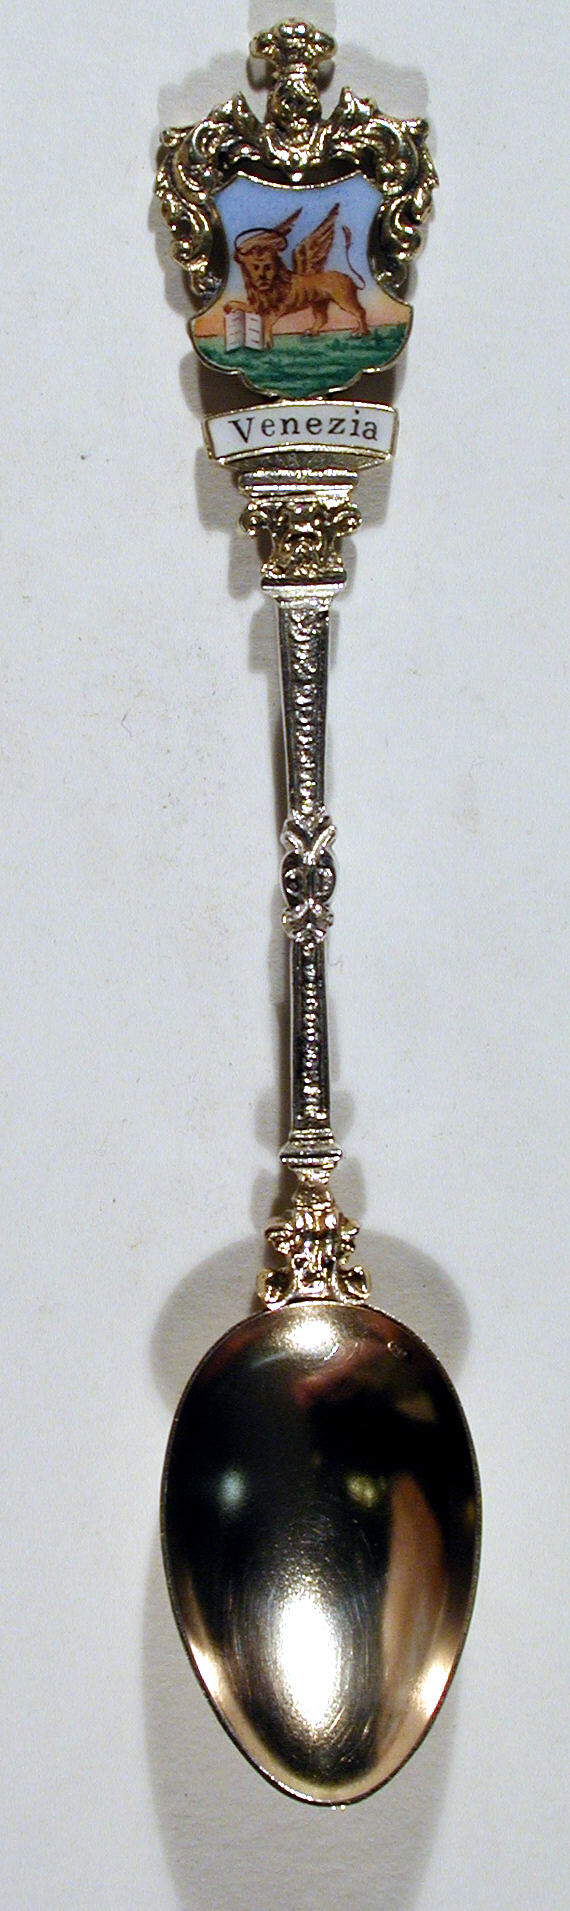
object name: souvenir spoon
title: Souvenir spoon with arms of Venice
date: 1867-1900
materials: enamel, gilt, silver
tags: coat of arms